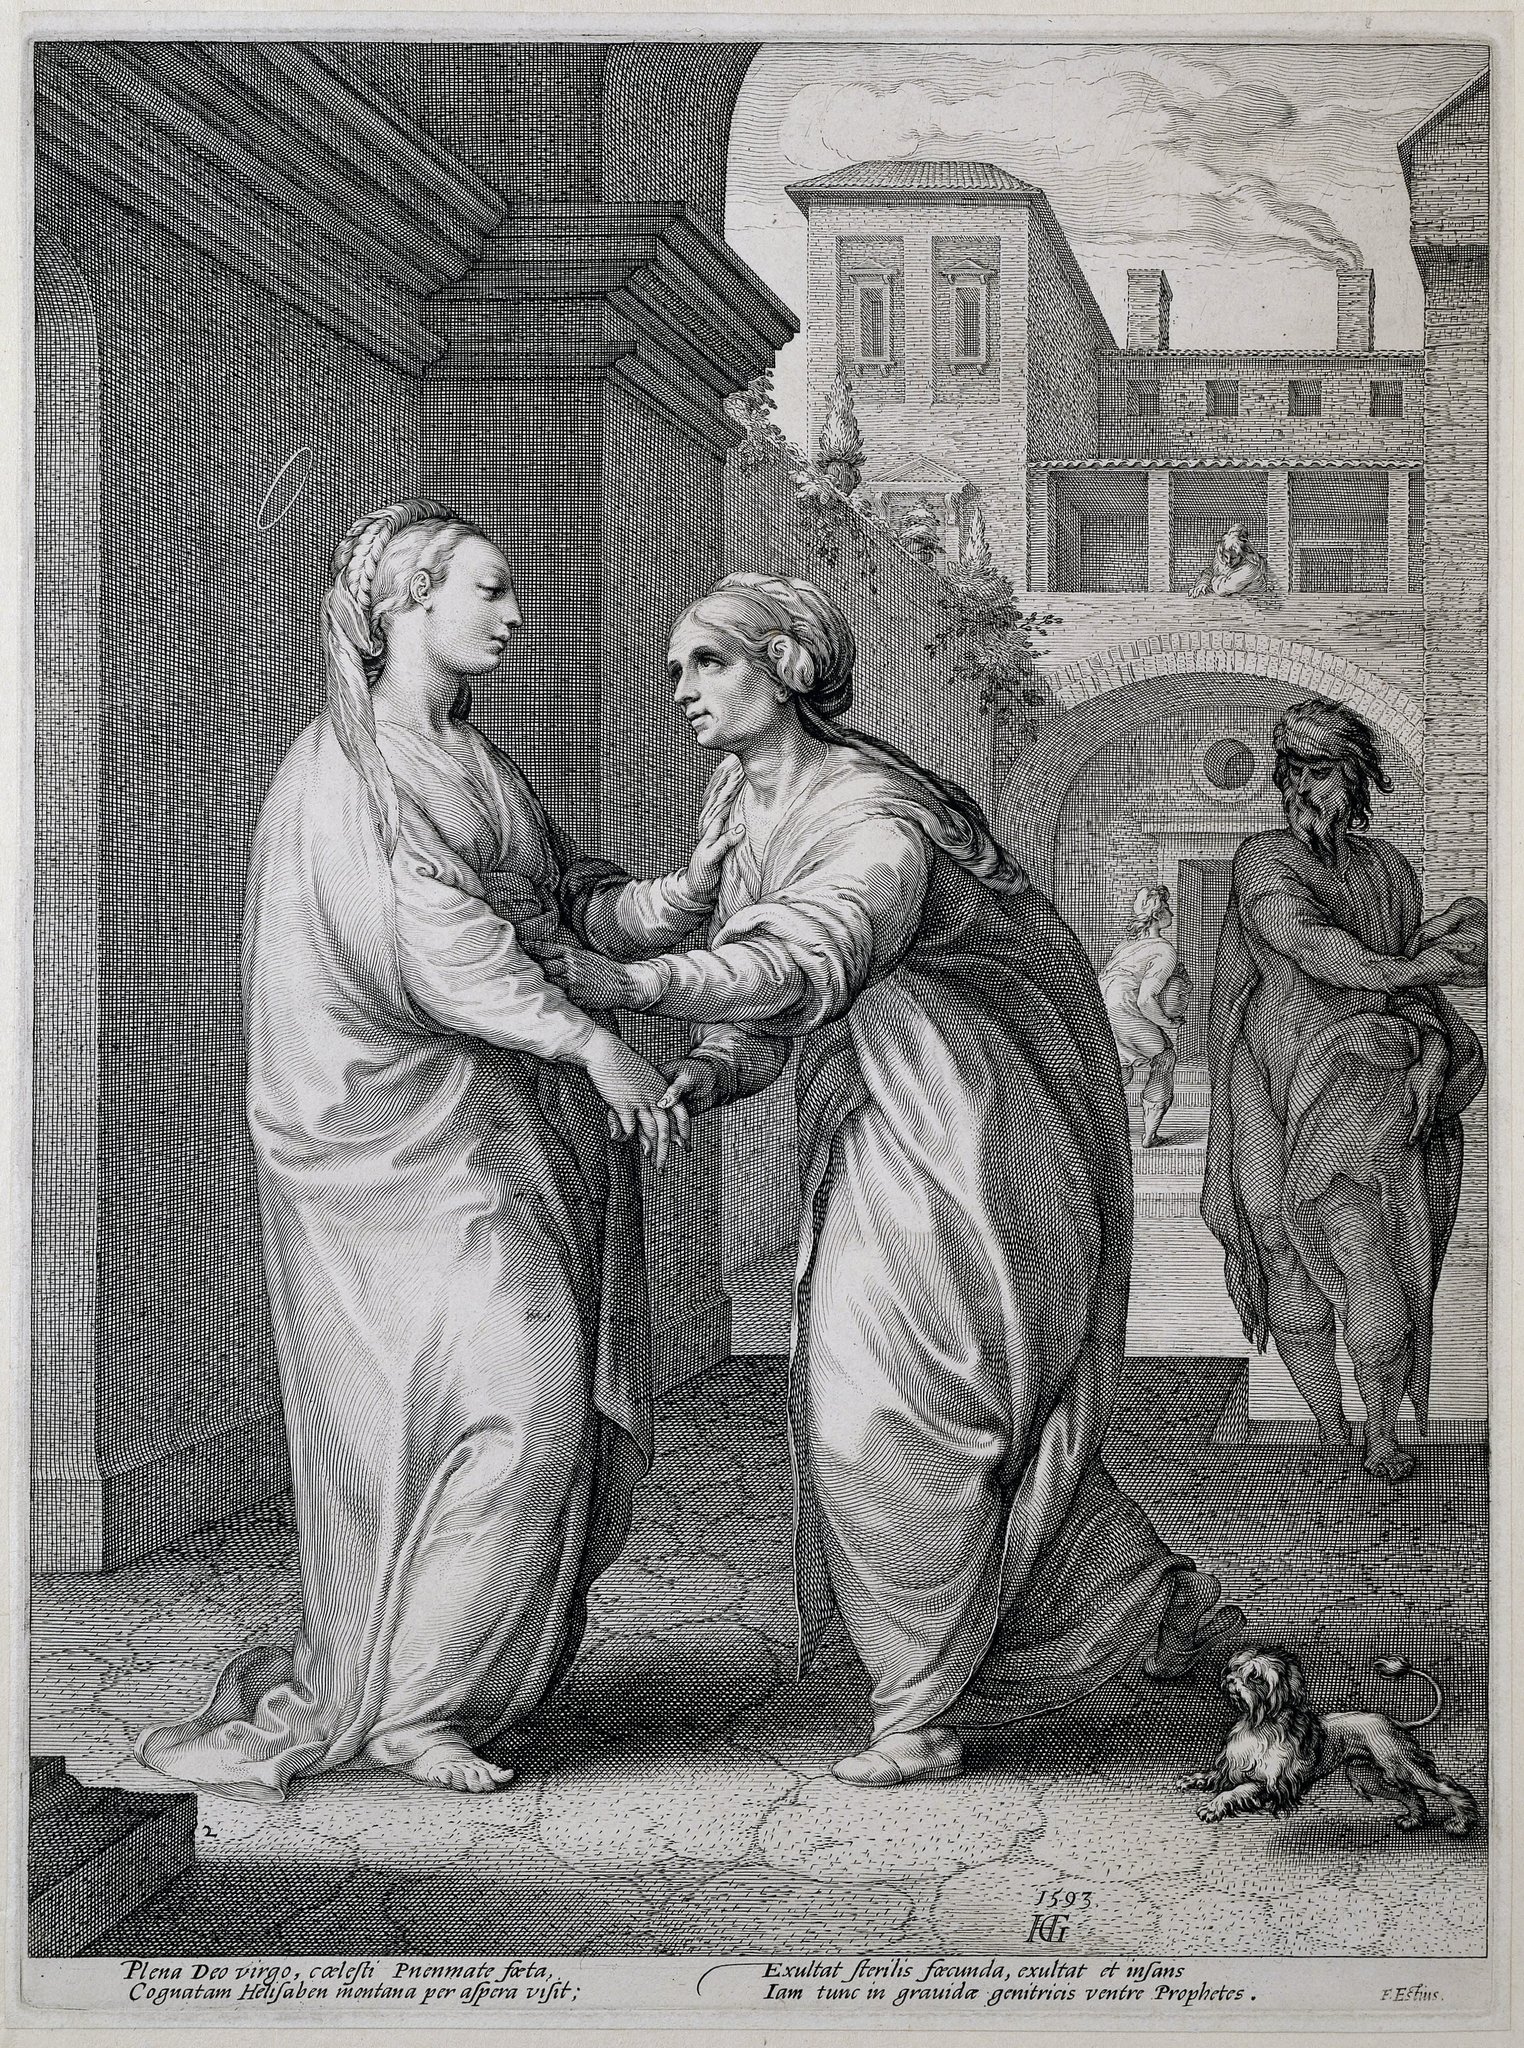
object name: print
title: Het vroege leven van Maria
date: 1593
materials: paper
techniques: engraving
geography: haarlem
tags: visitation (possibly joseph and/or zacharias present) (luke 1:39-56)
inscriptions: collector's mark: Lugt 240, date: ‘1593.’, caption: ‘Plena Deo virgo ... ventre Prophetes.’, signature: ‘HG.’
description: Maria en Elizabeth, beiden net zwanger, ontmoeten elkaar bij een stadspoort. Onder de voorstelling vier Latijnse versregels. Deze prent is onderdeel van een serie van zes prenten met scènes uit het vroege leven van Maria. Die worden de 'Meesterstukken' genoemd, omdat Goltzius er het werk van verschillende illustere voorgangers in heeft nagebootst.